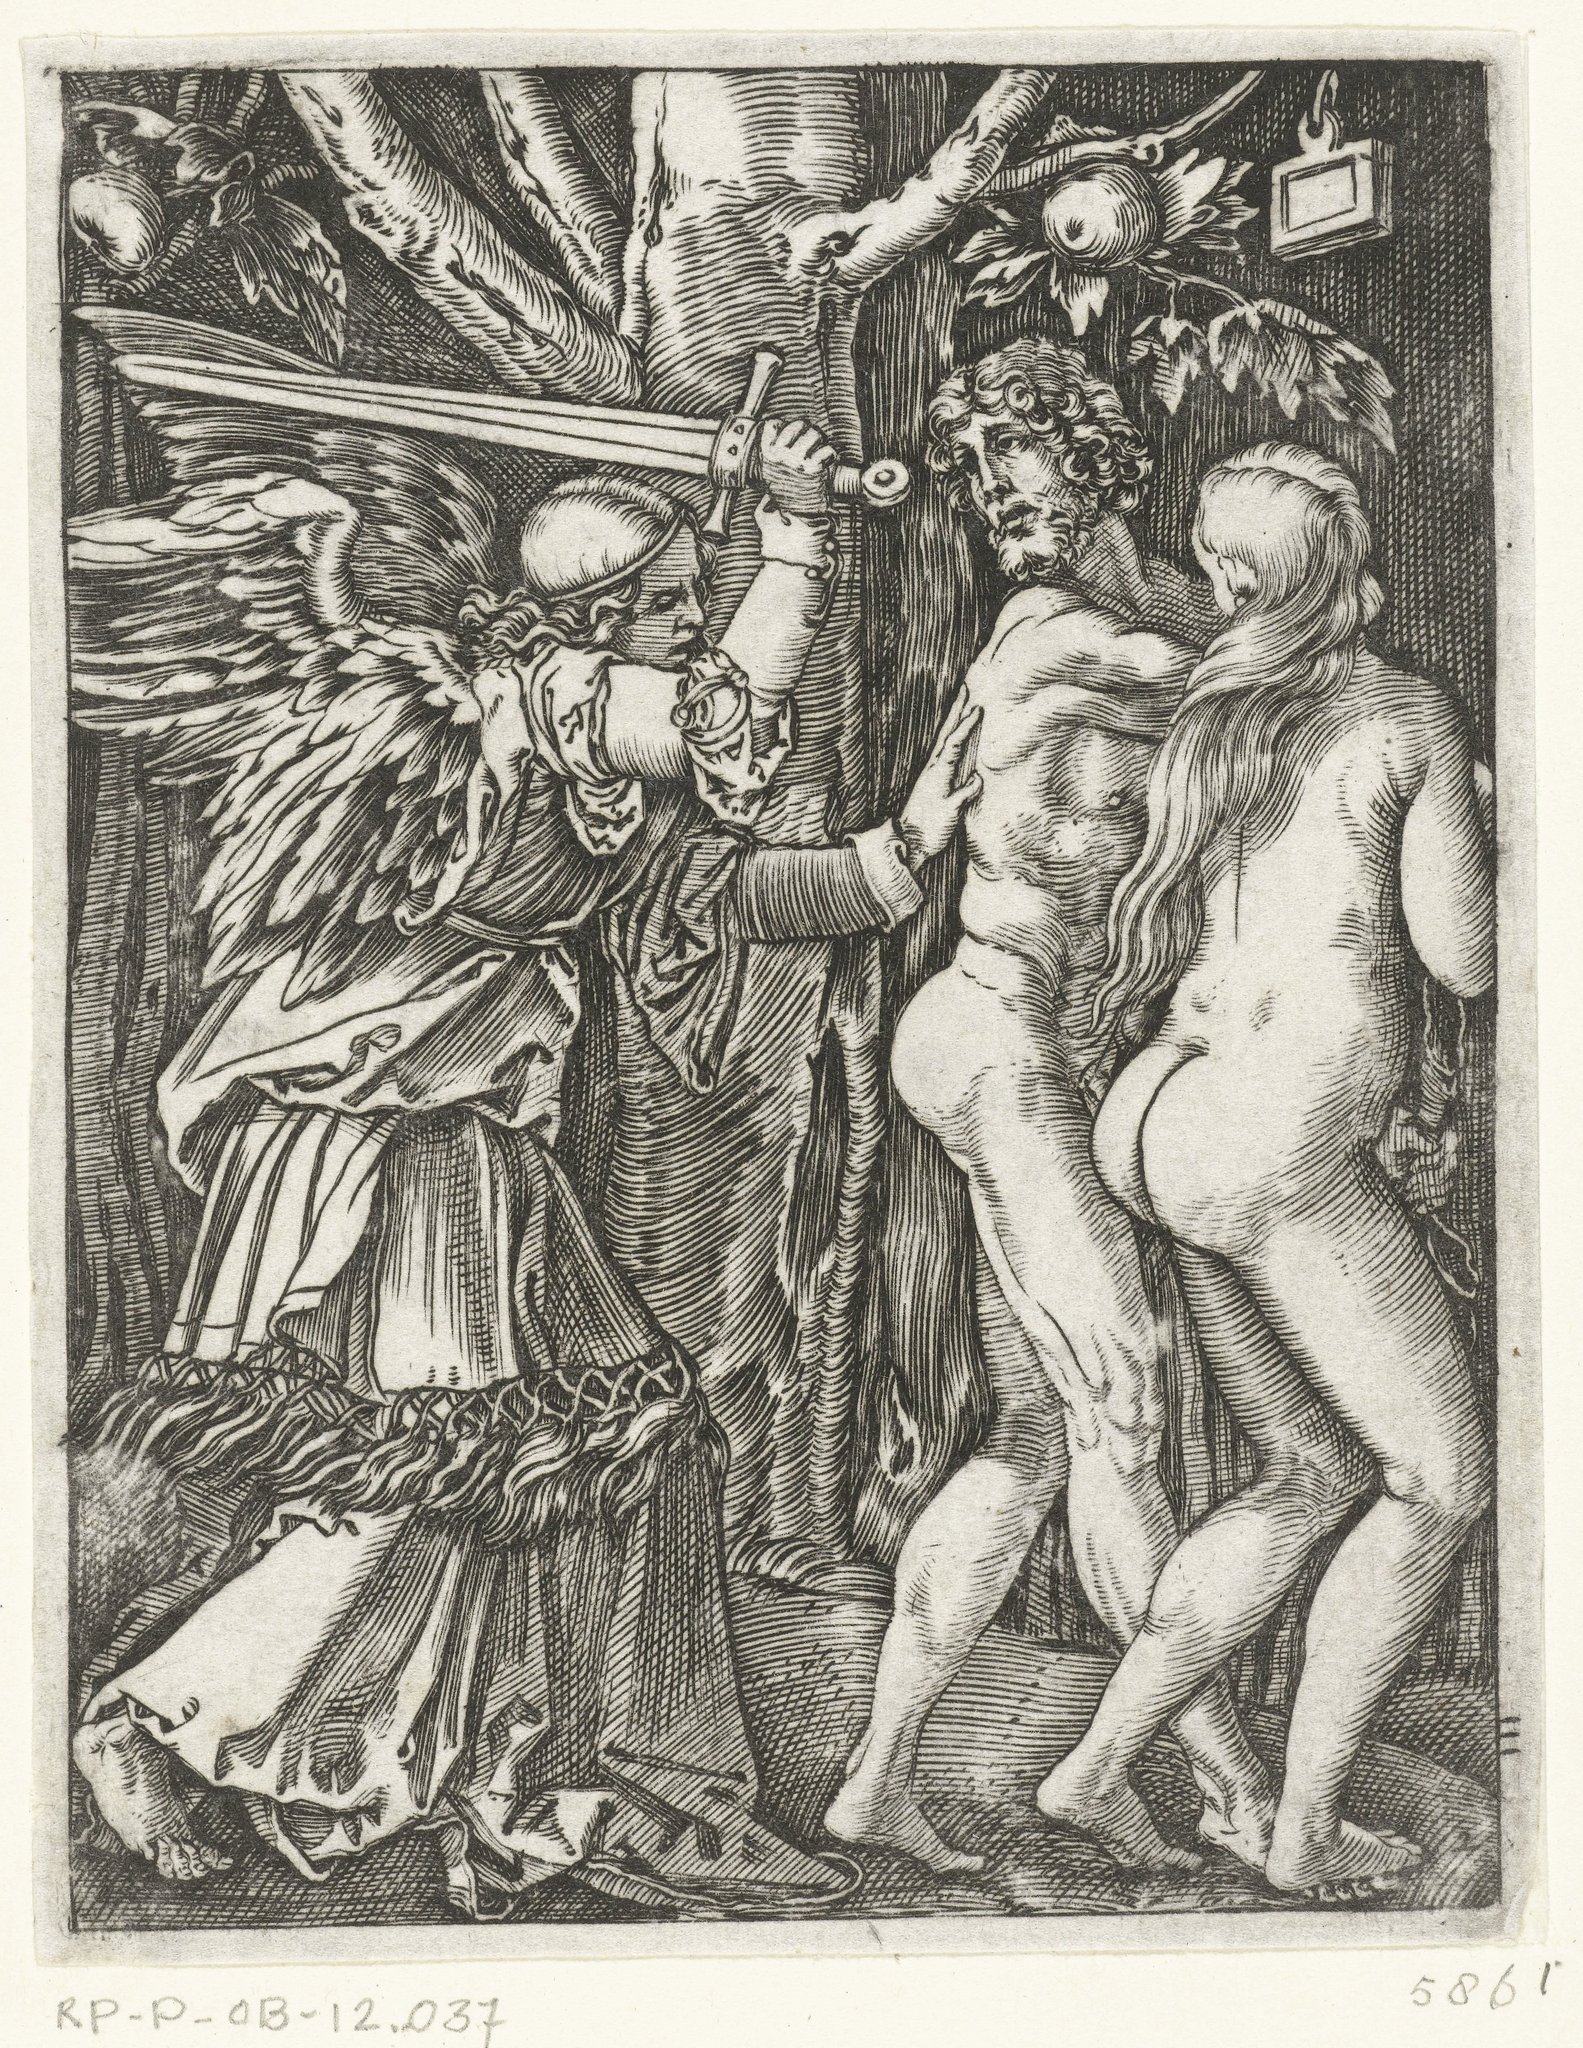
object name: print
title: Expulsion from Paradise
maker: marcantonio raimondi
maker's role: print maker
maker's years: 1470-1534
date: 1510-1515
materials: paper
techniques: engraving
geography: italy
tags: expulsion of adam and eve from paradise (genesis 3:22-24)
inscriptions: collector's mark: Lugt 12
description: Prent uit een serie van zevenendertig prenten met als onderwerp het levensverhaal van Christus, getiteld Passie van Christus.